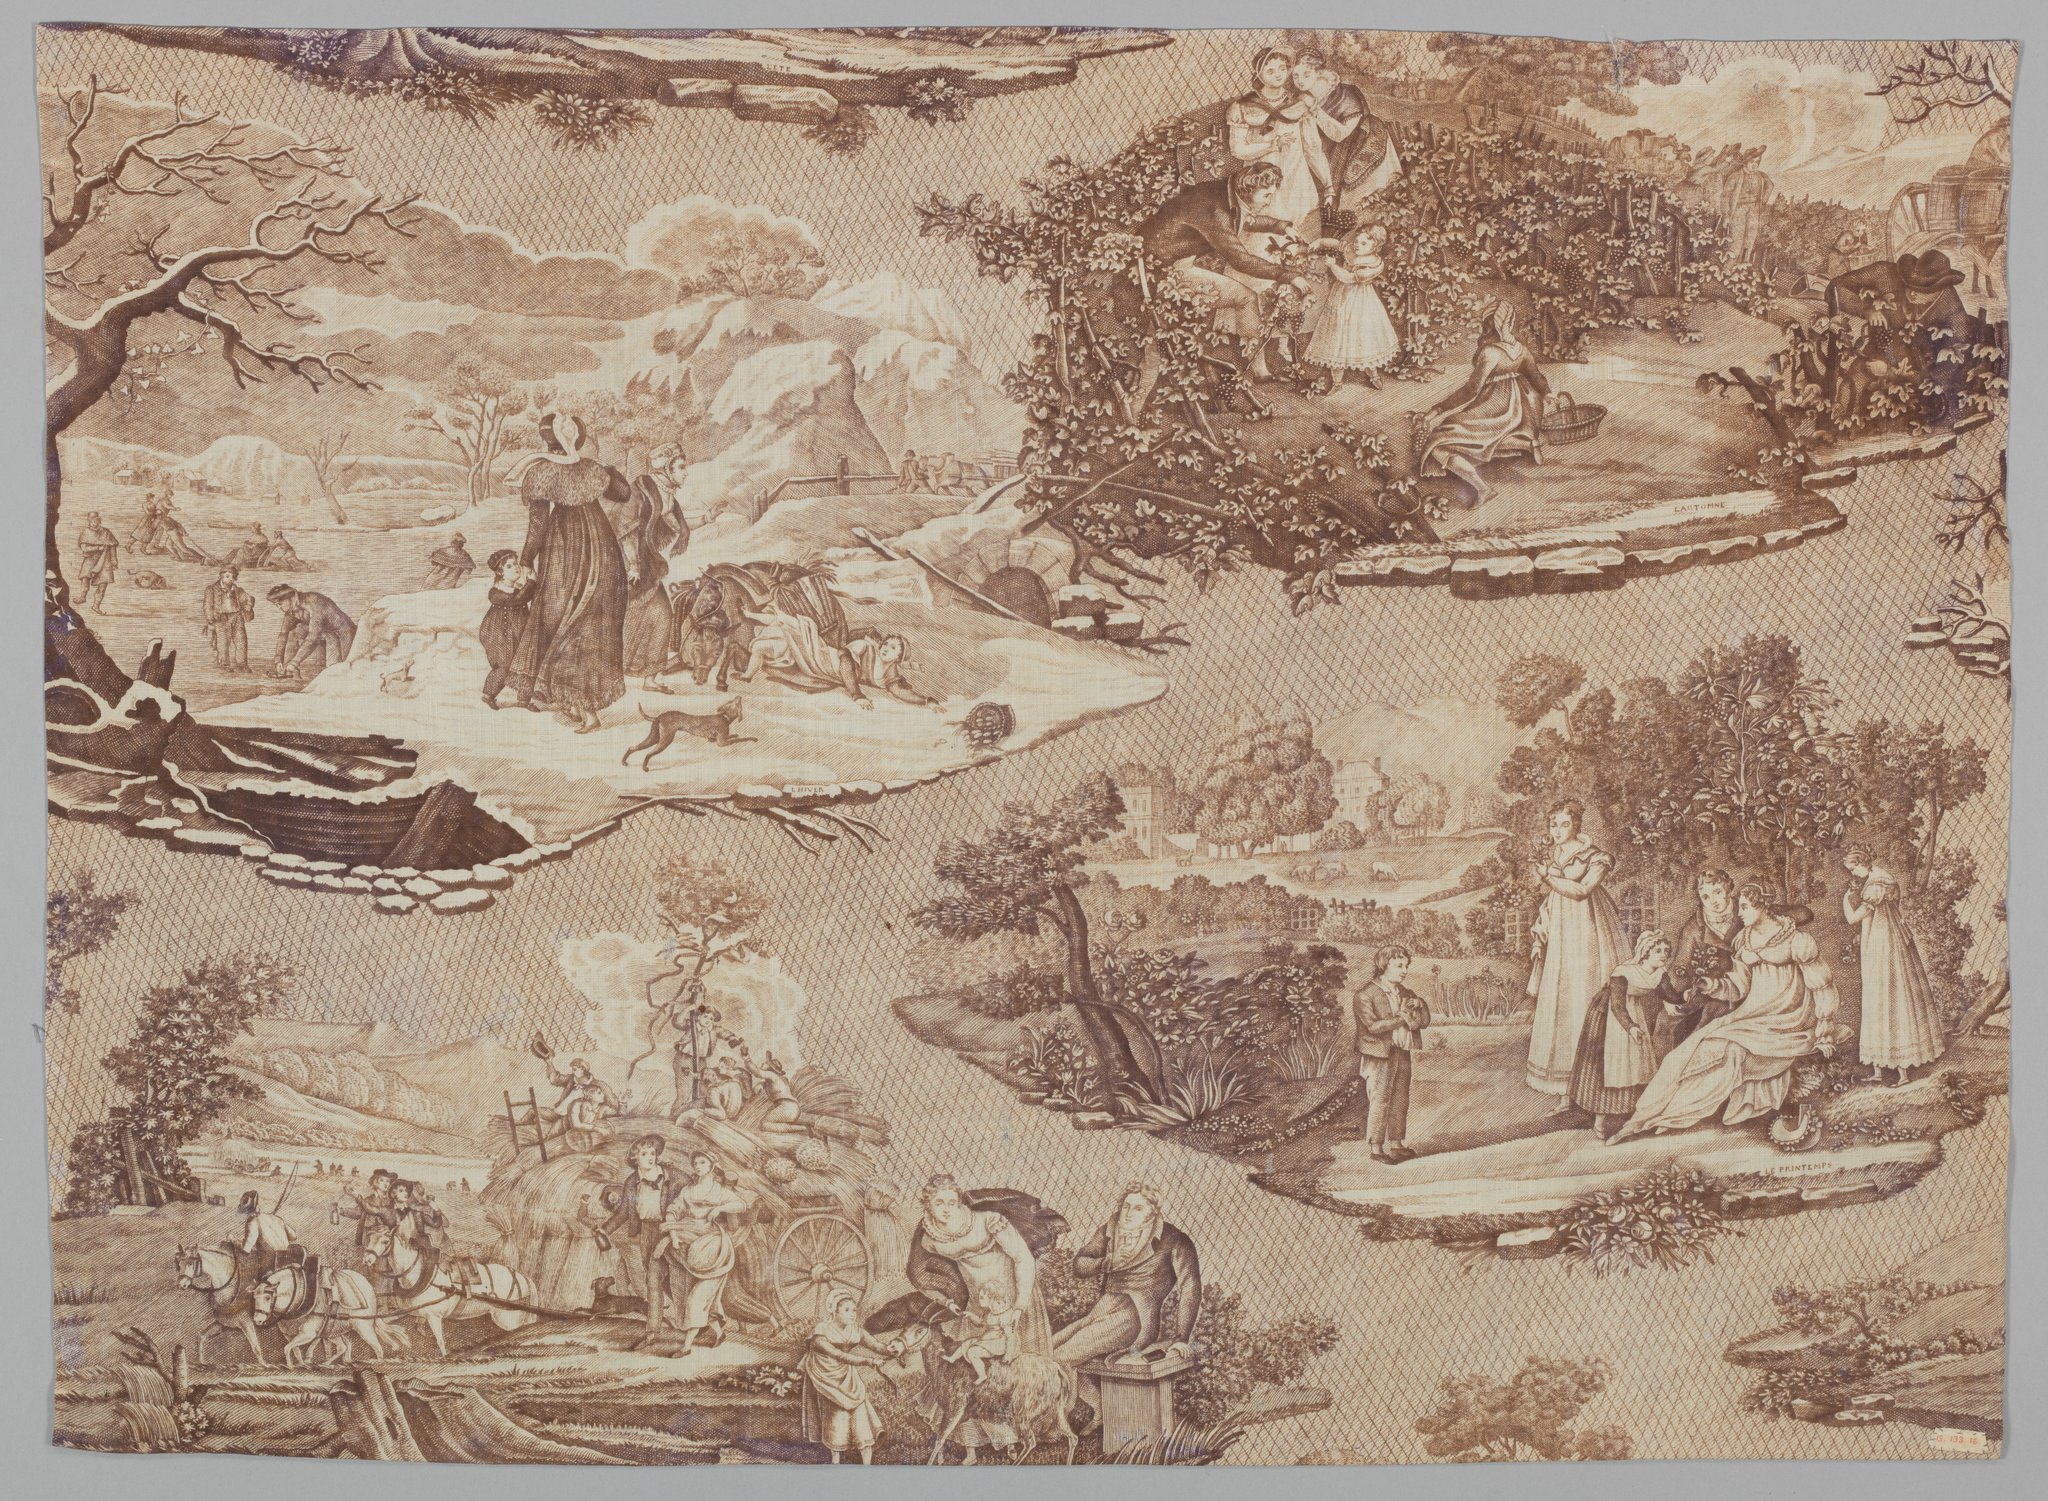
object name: furnishing textile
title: Pictorial print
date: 1820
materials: cotton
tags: children,men,women,dogs,horses,winter